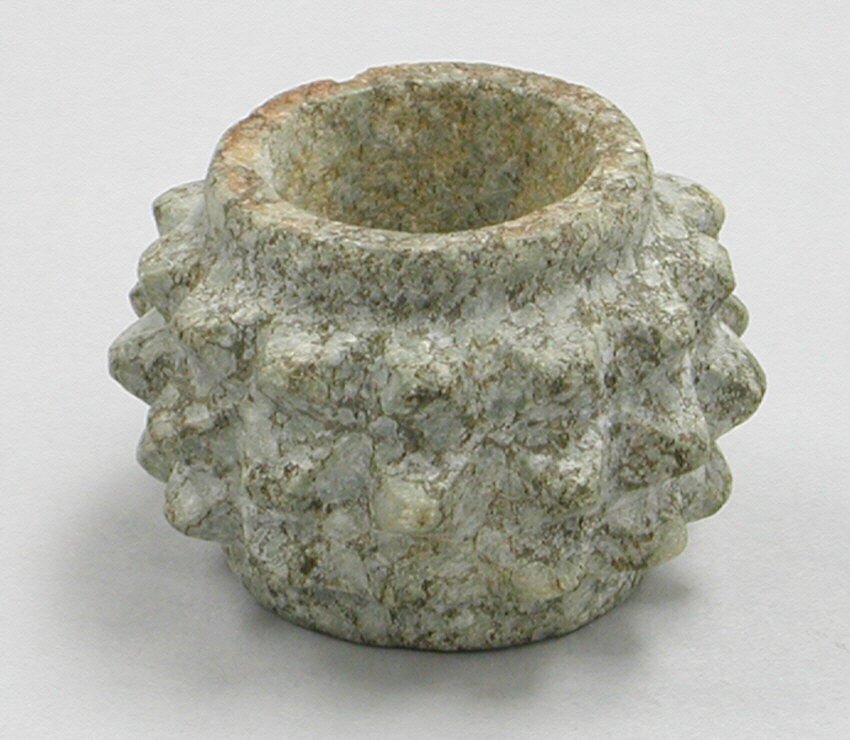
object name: mace head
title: Stone Mace Head with Spikes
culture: mexican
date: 1501-1600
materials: stone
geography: mexico